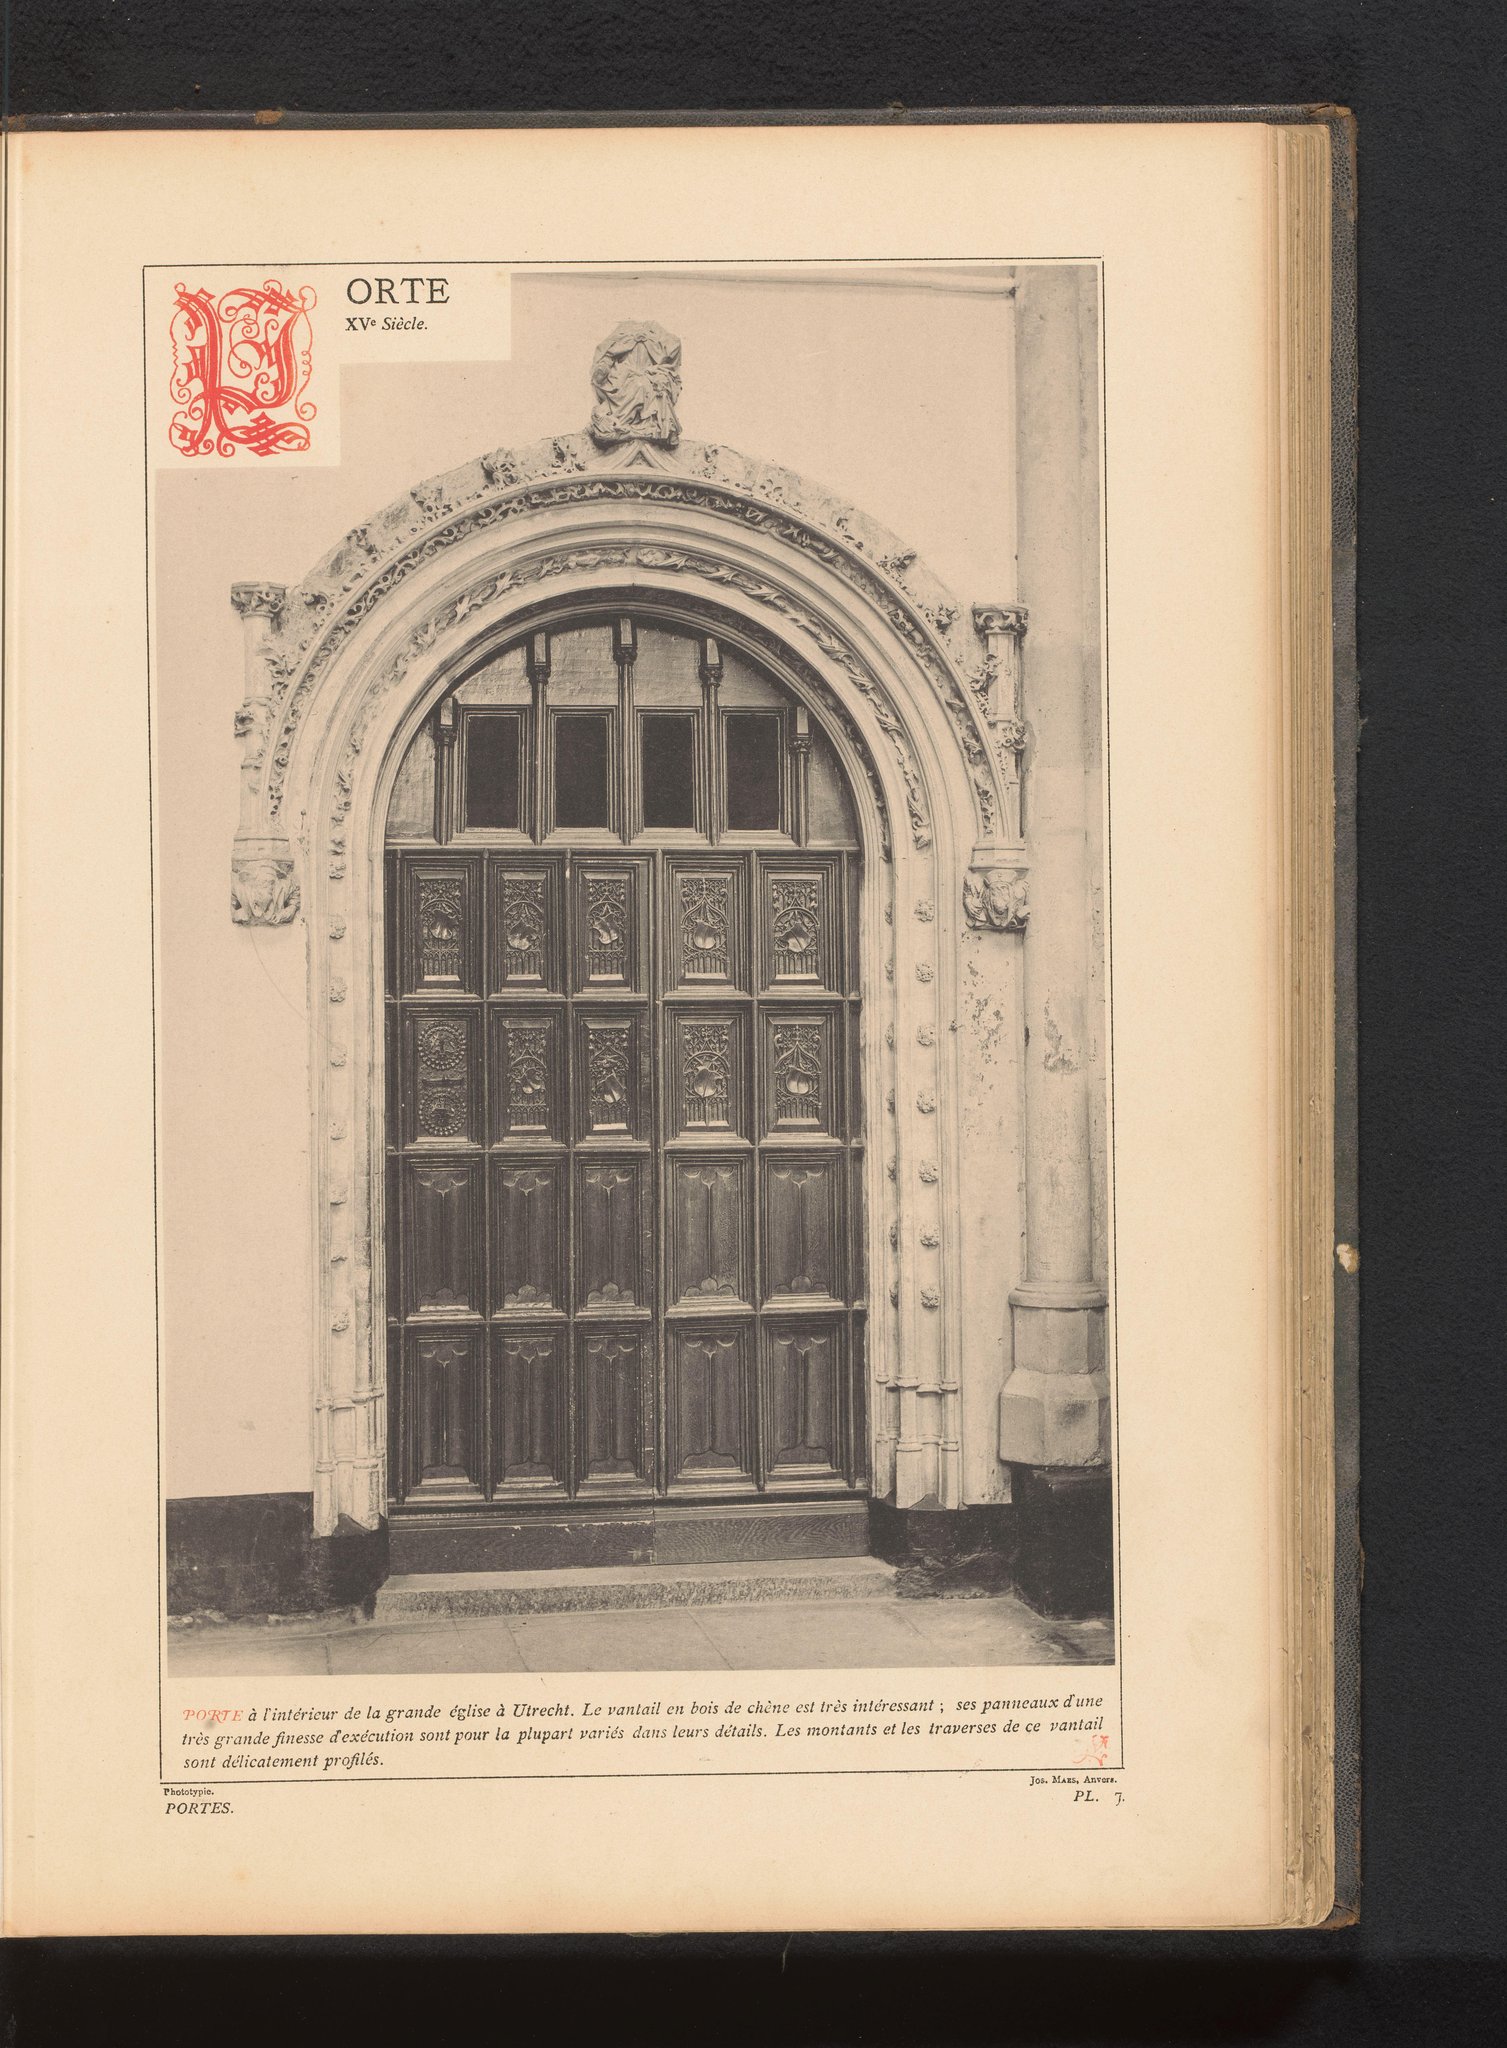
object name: page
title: Portaal in de Dom van Utrecht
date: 1881-1889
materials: paper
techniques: photograph, photolithography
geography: antwerp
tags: interior of church, closed door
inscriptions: inscription: ‘PORTES. PL. 7.’, monogram: ‘JJvY’, inscription: ‘PORTE à l'intérieur (...)’